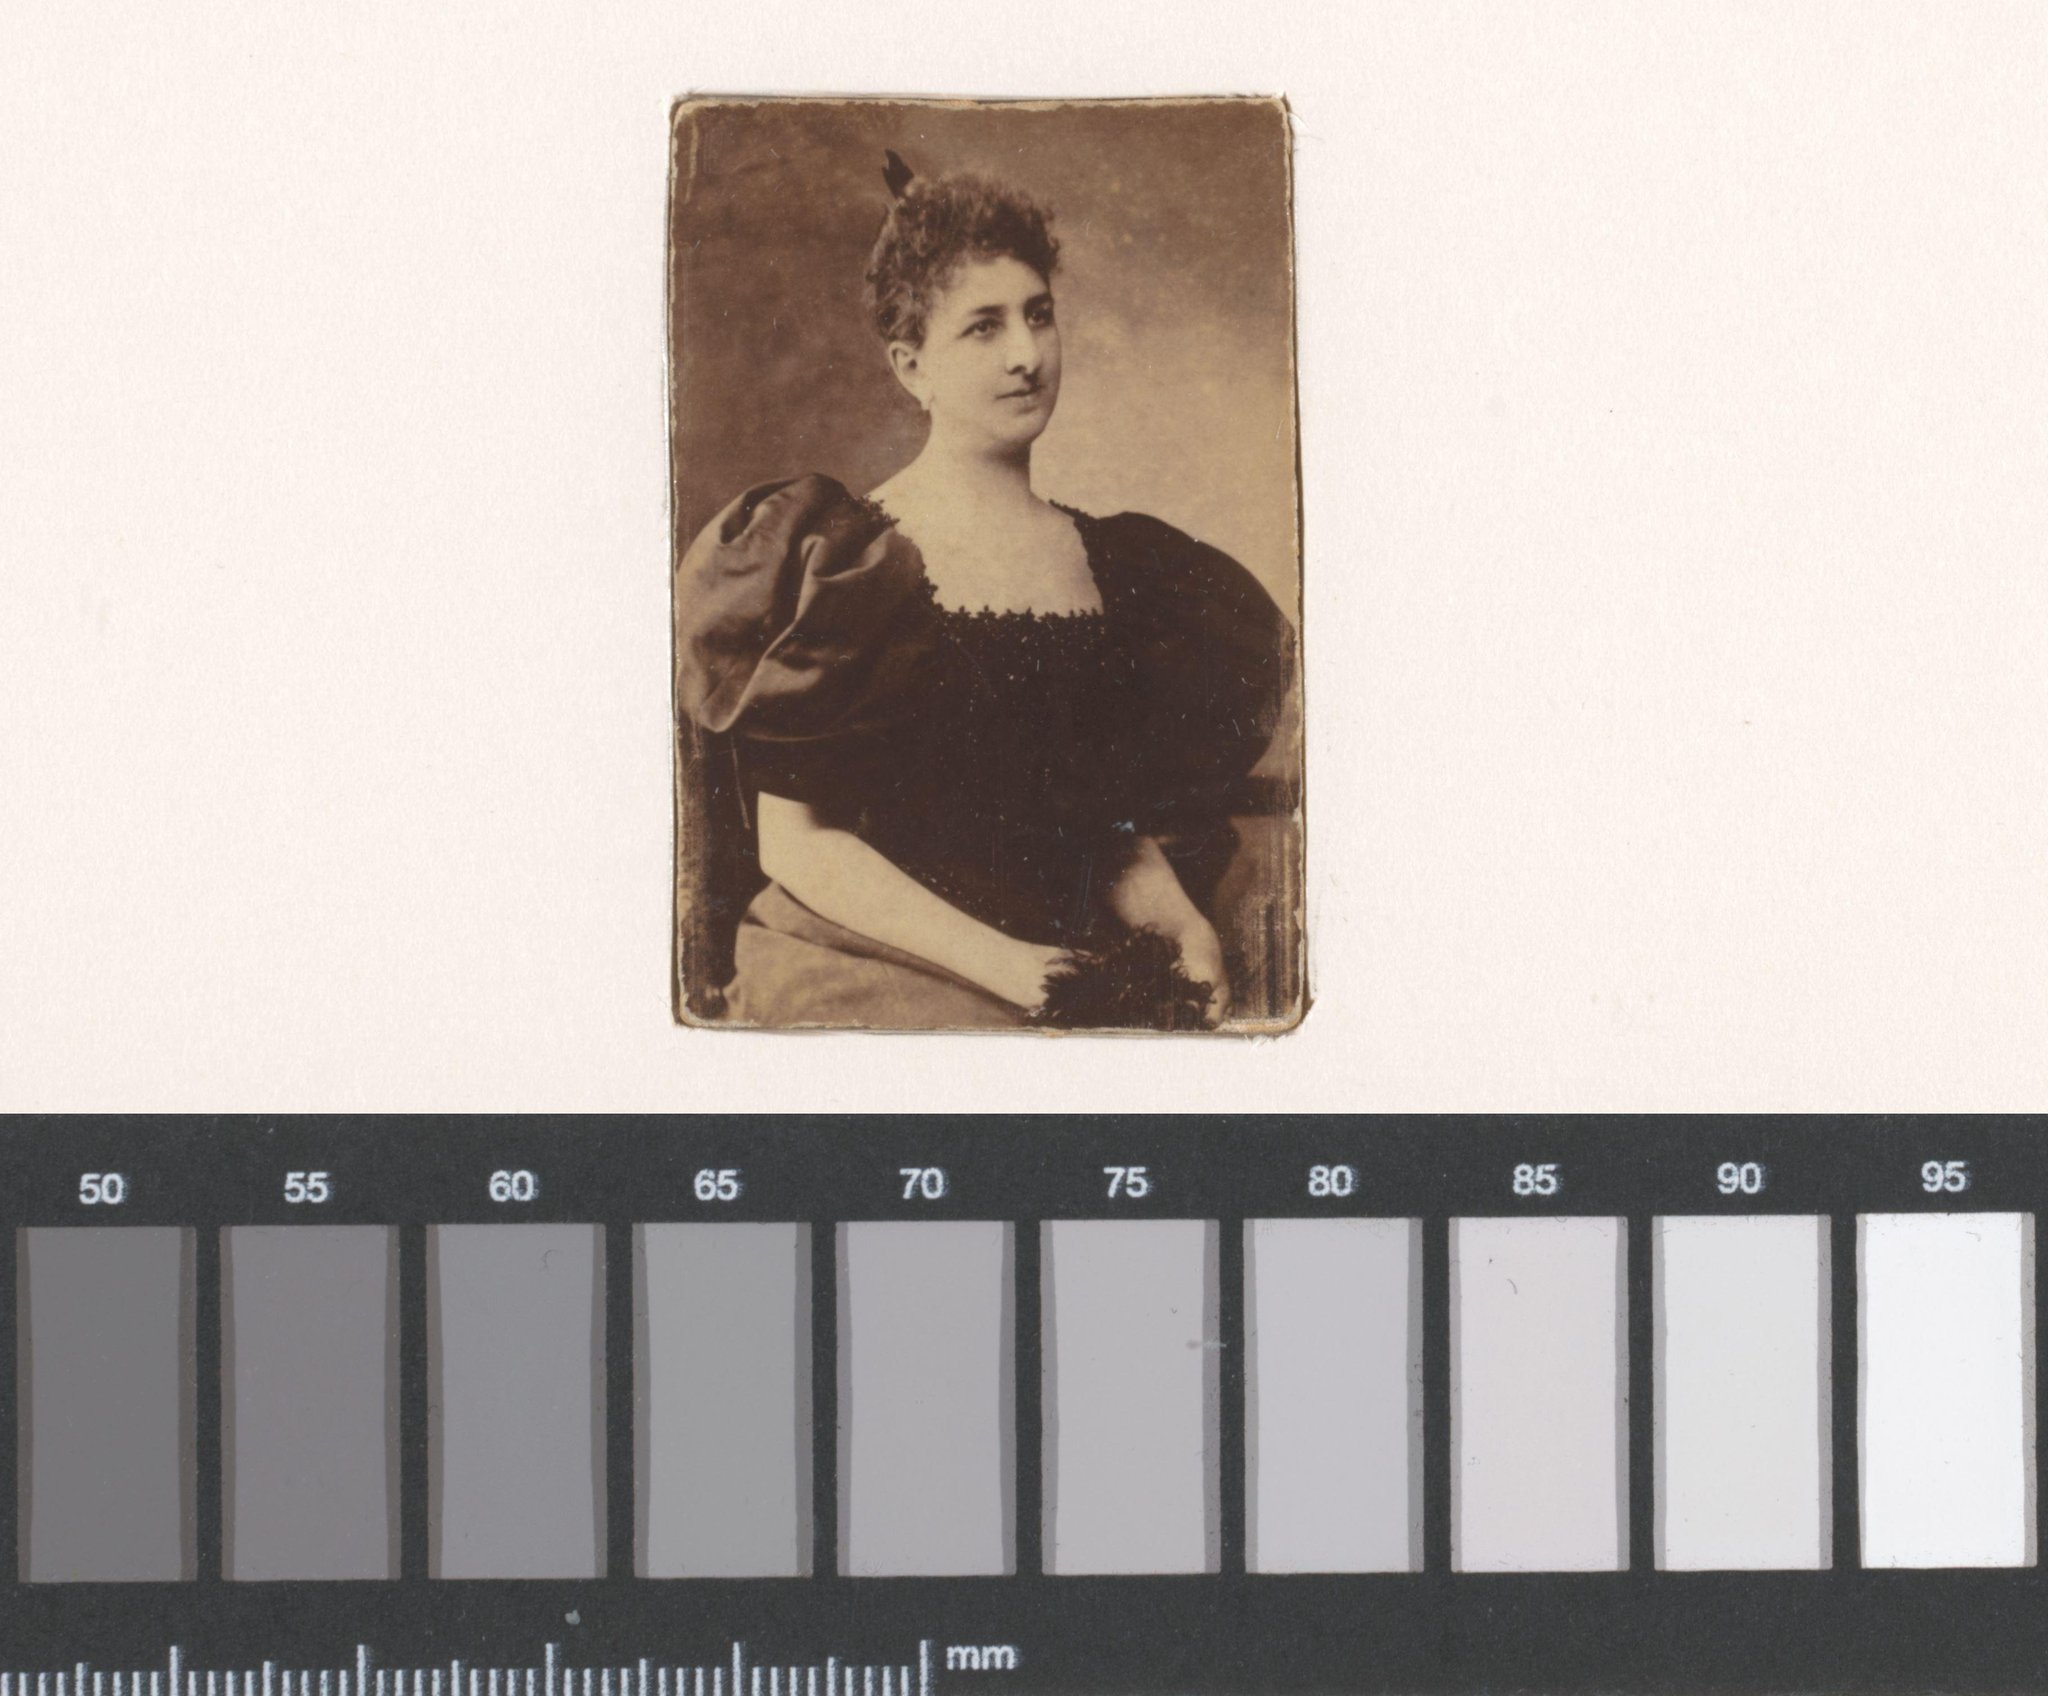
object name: photograph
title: Portret van Charlotte van Braam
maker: richard kameke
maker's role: fotograaf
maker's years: 1847-1898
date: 1887-1898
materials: paper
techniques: albumen print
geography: the hague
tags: arnhem, charlotte catharina van braam, historical persons - bb - woman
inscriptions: inscription: ‘Zie/ Kameke/ La Haye’